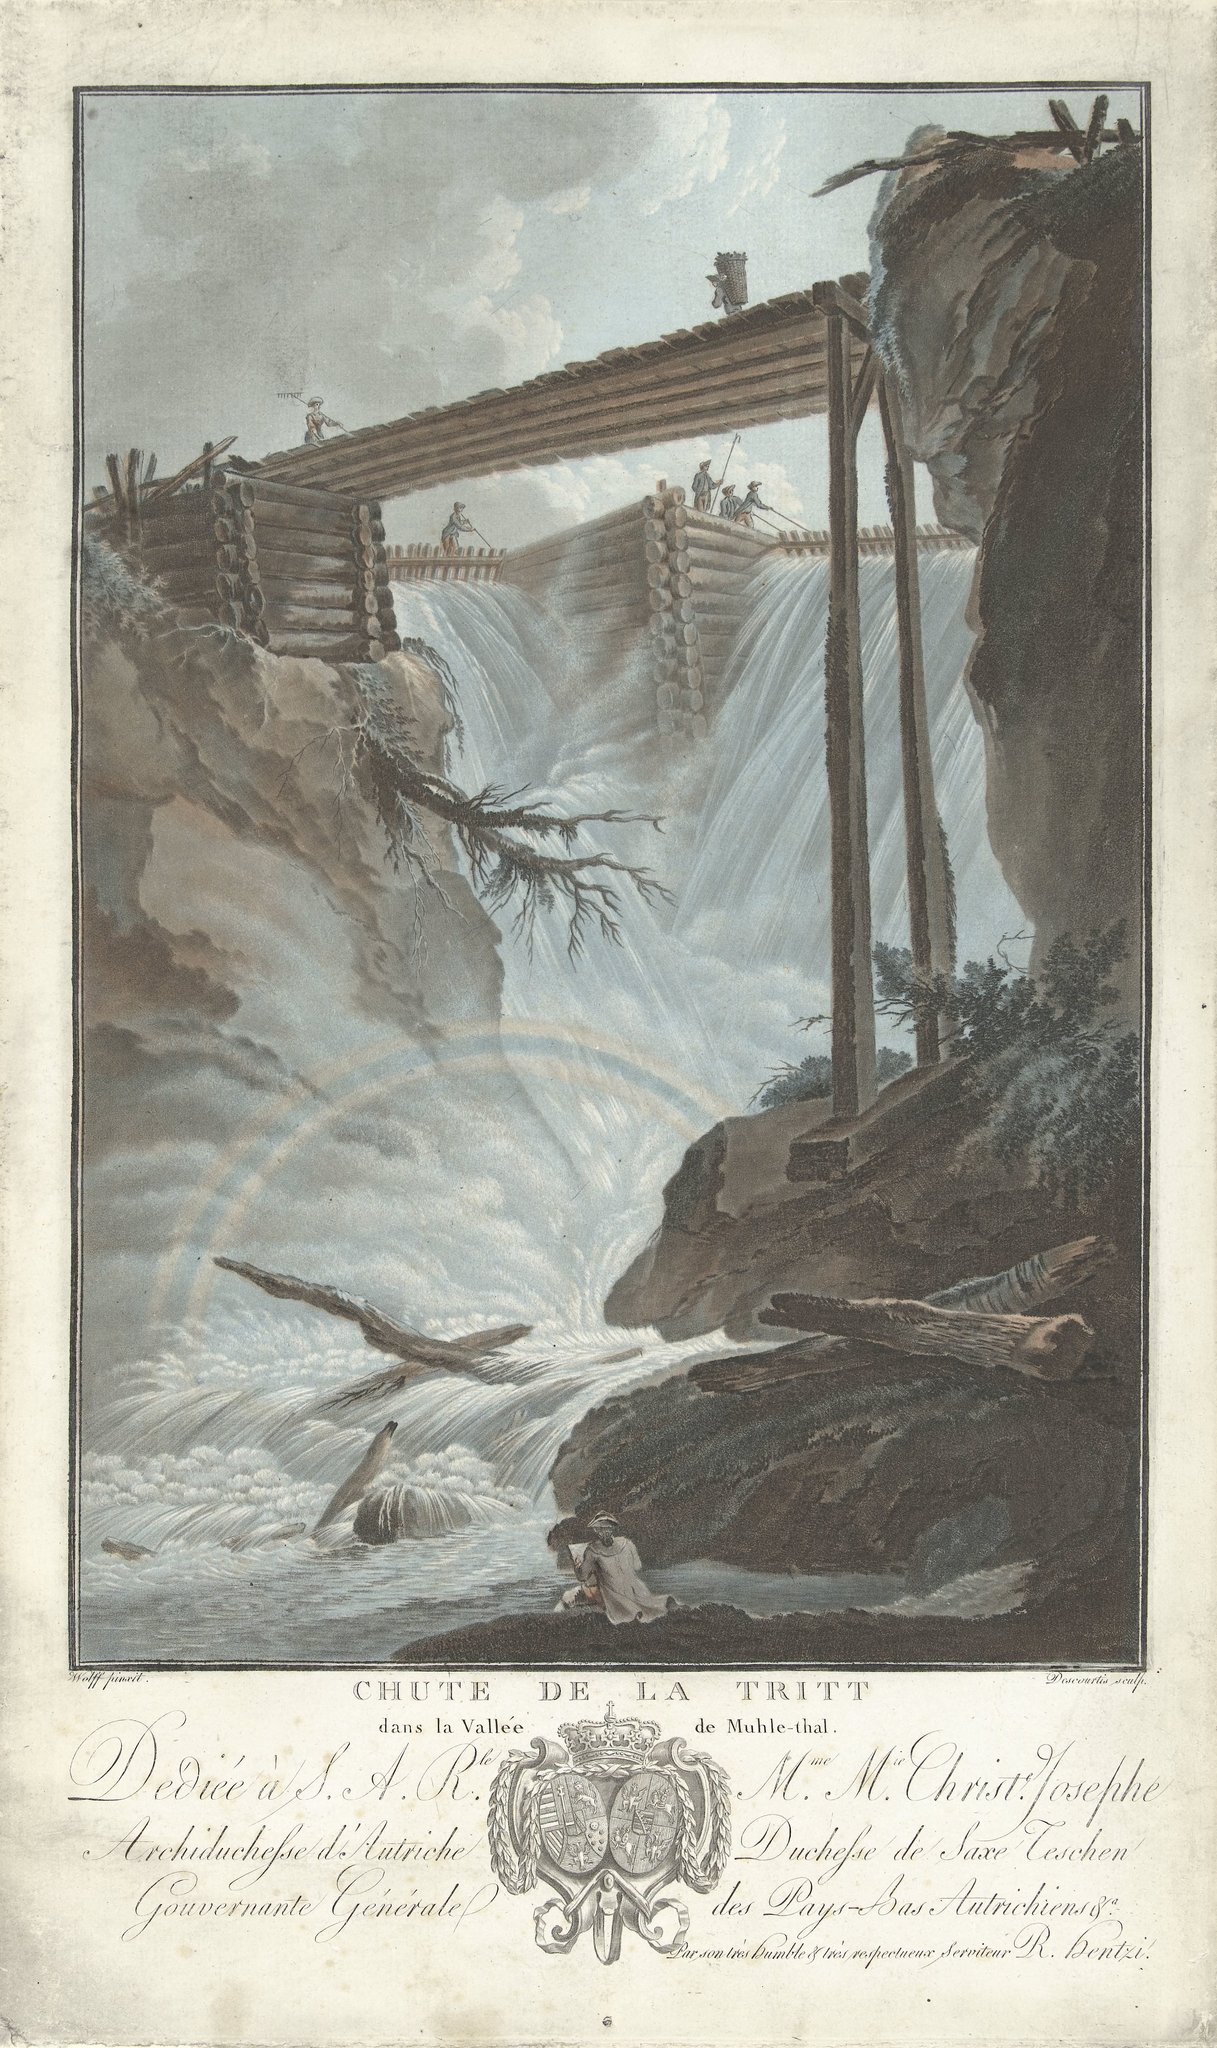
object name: print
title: Chute de la Tritt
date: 1763-1785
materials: paper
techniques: etching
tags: waterfall, switzerland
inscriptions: collector's mark: Lugt 2228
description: Gezicht op de waterval in het Mühlethal in Zwitserland. Over de kloof een houten brug. Op de voorgrond een regenboog en op de oever een man aan het tekenen. Onder de voorstelling tekst en een wapenschild.